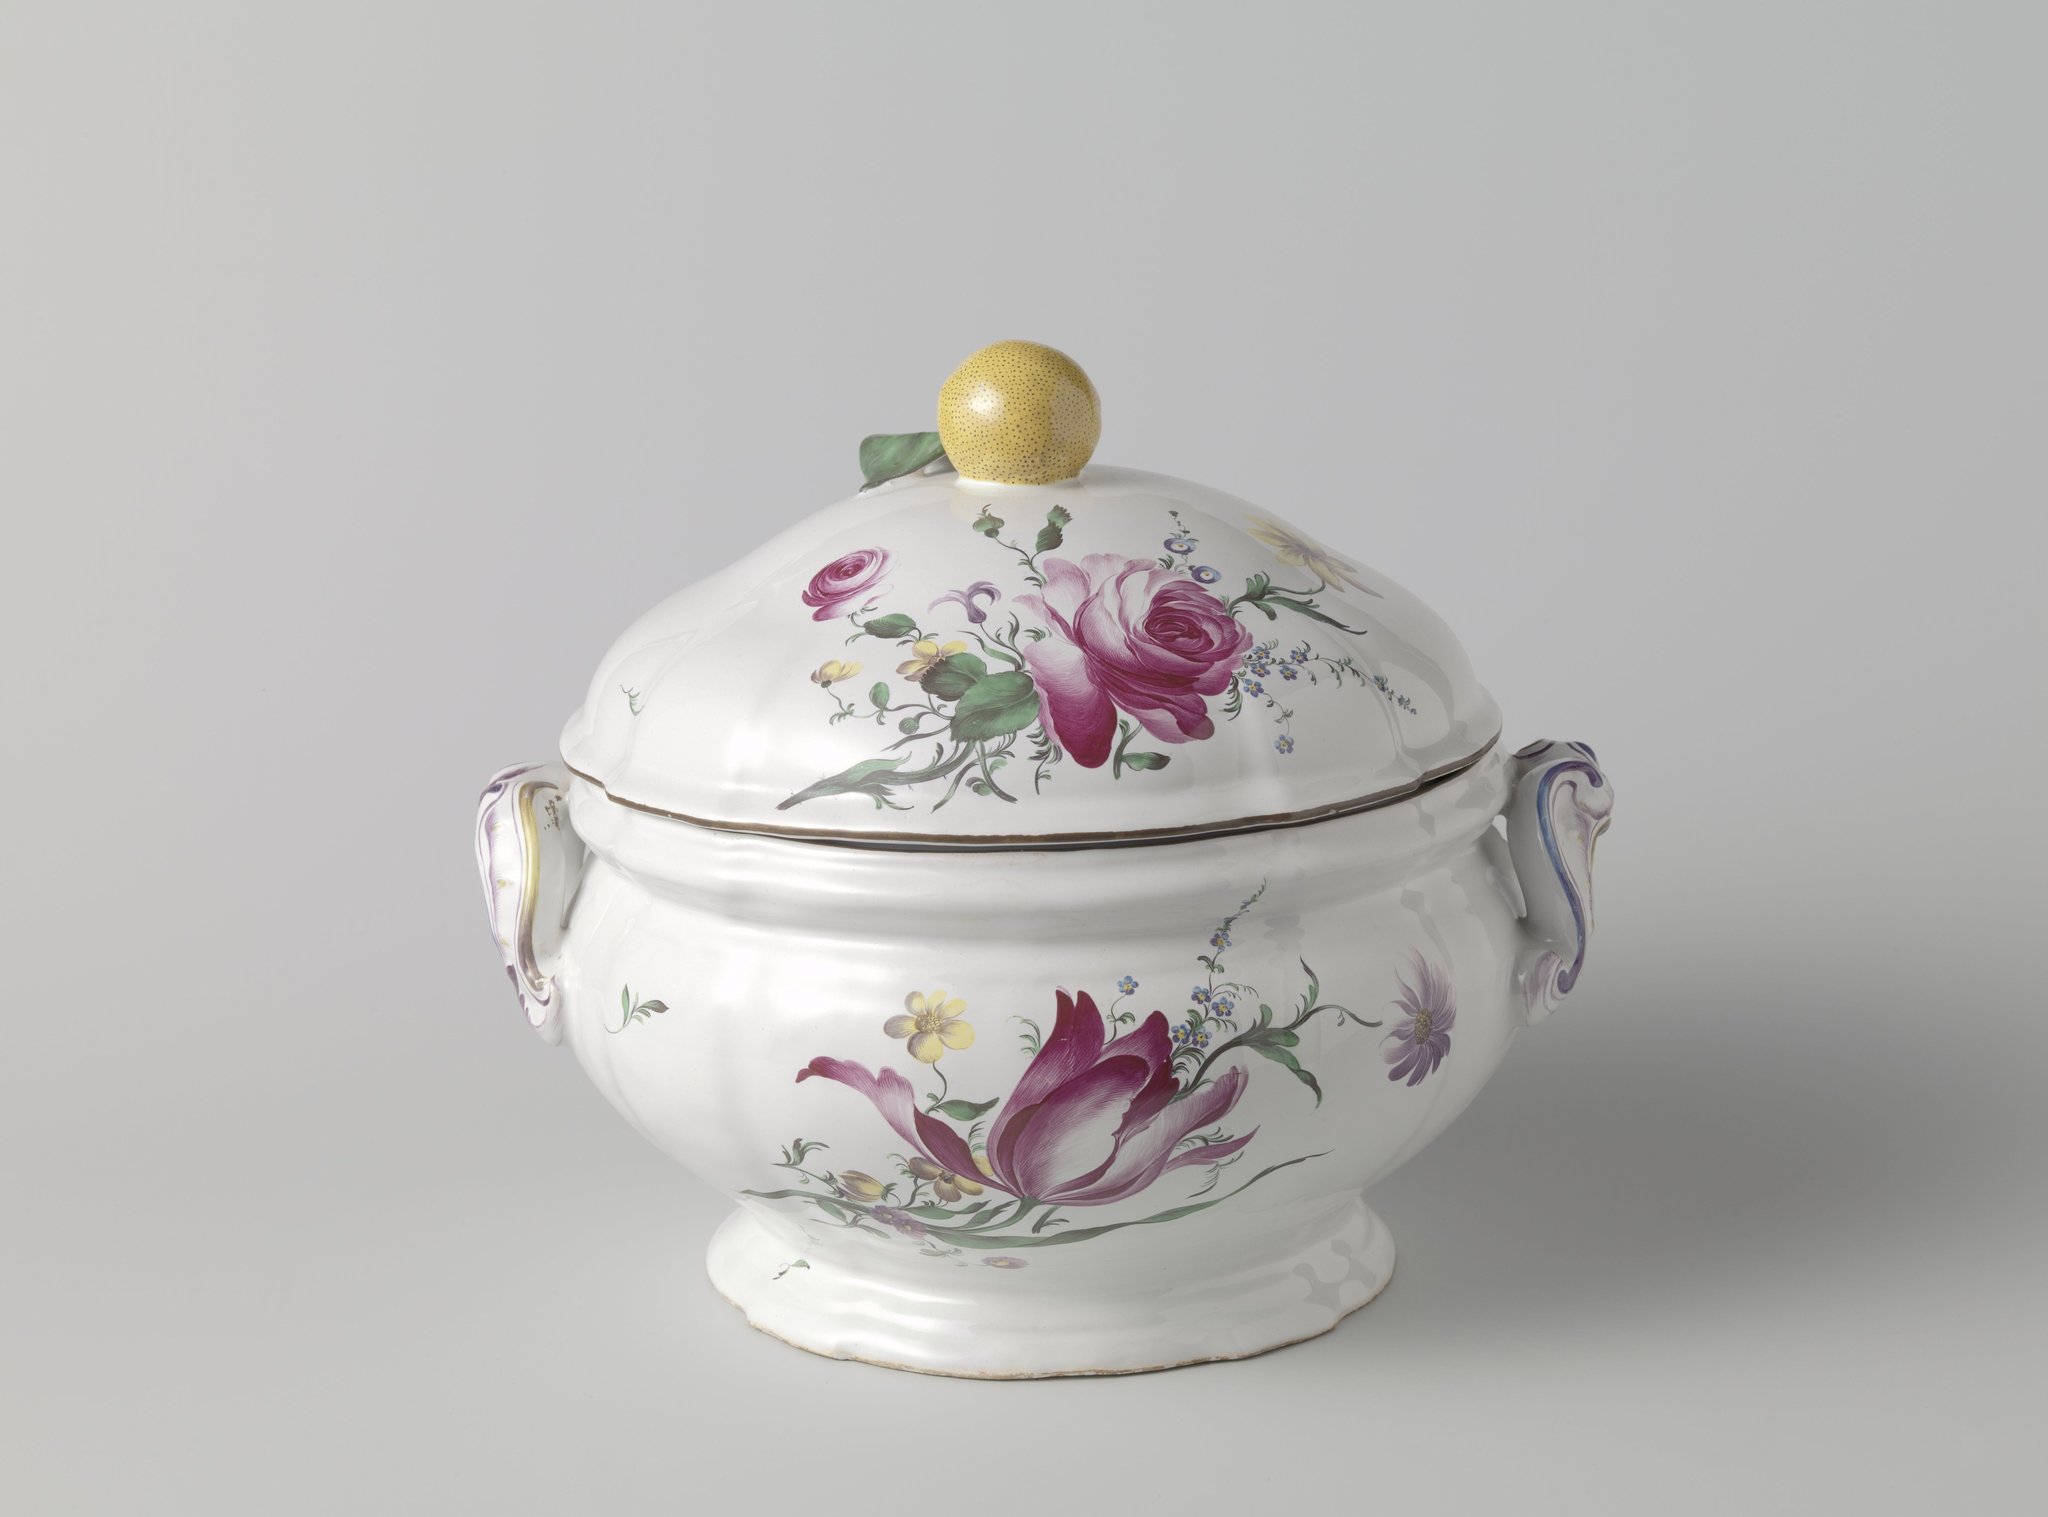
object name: tureen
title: Ronde terrine met deksel en onderschotel van aardewerk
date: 1760-1775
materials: faience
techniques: kiln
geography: straatsburg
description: Tureen and stand. Faience with petit feu decoration. Strasbourg (France), c. 1760 - 1775, factory of Joseph Hannong. The tureen marked J.H. for Joseph Hannong, the stand P.H. for Paul Hannong. On anonymous loan.